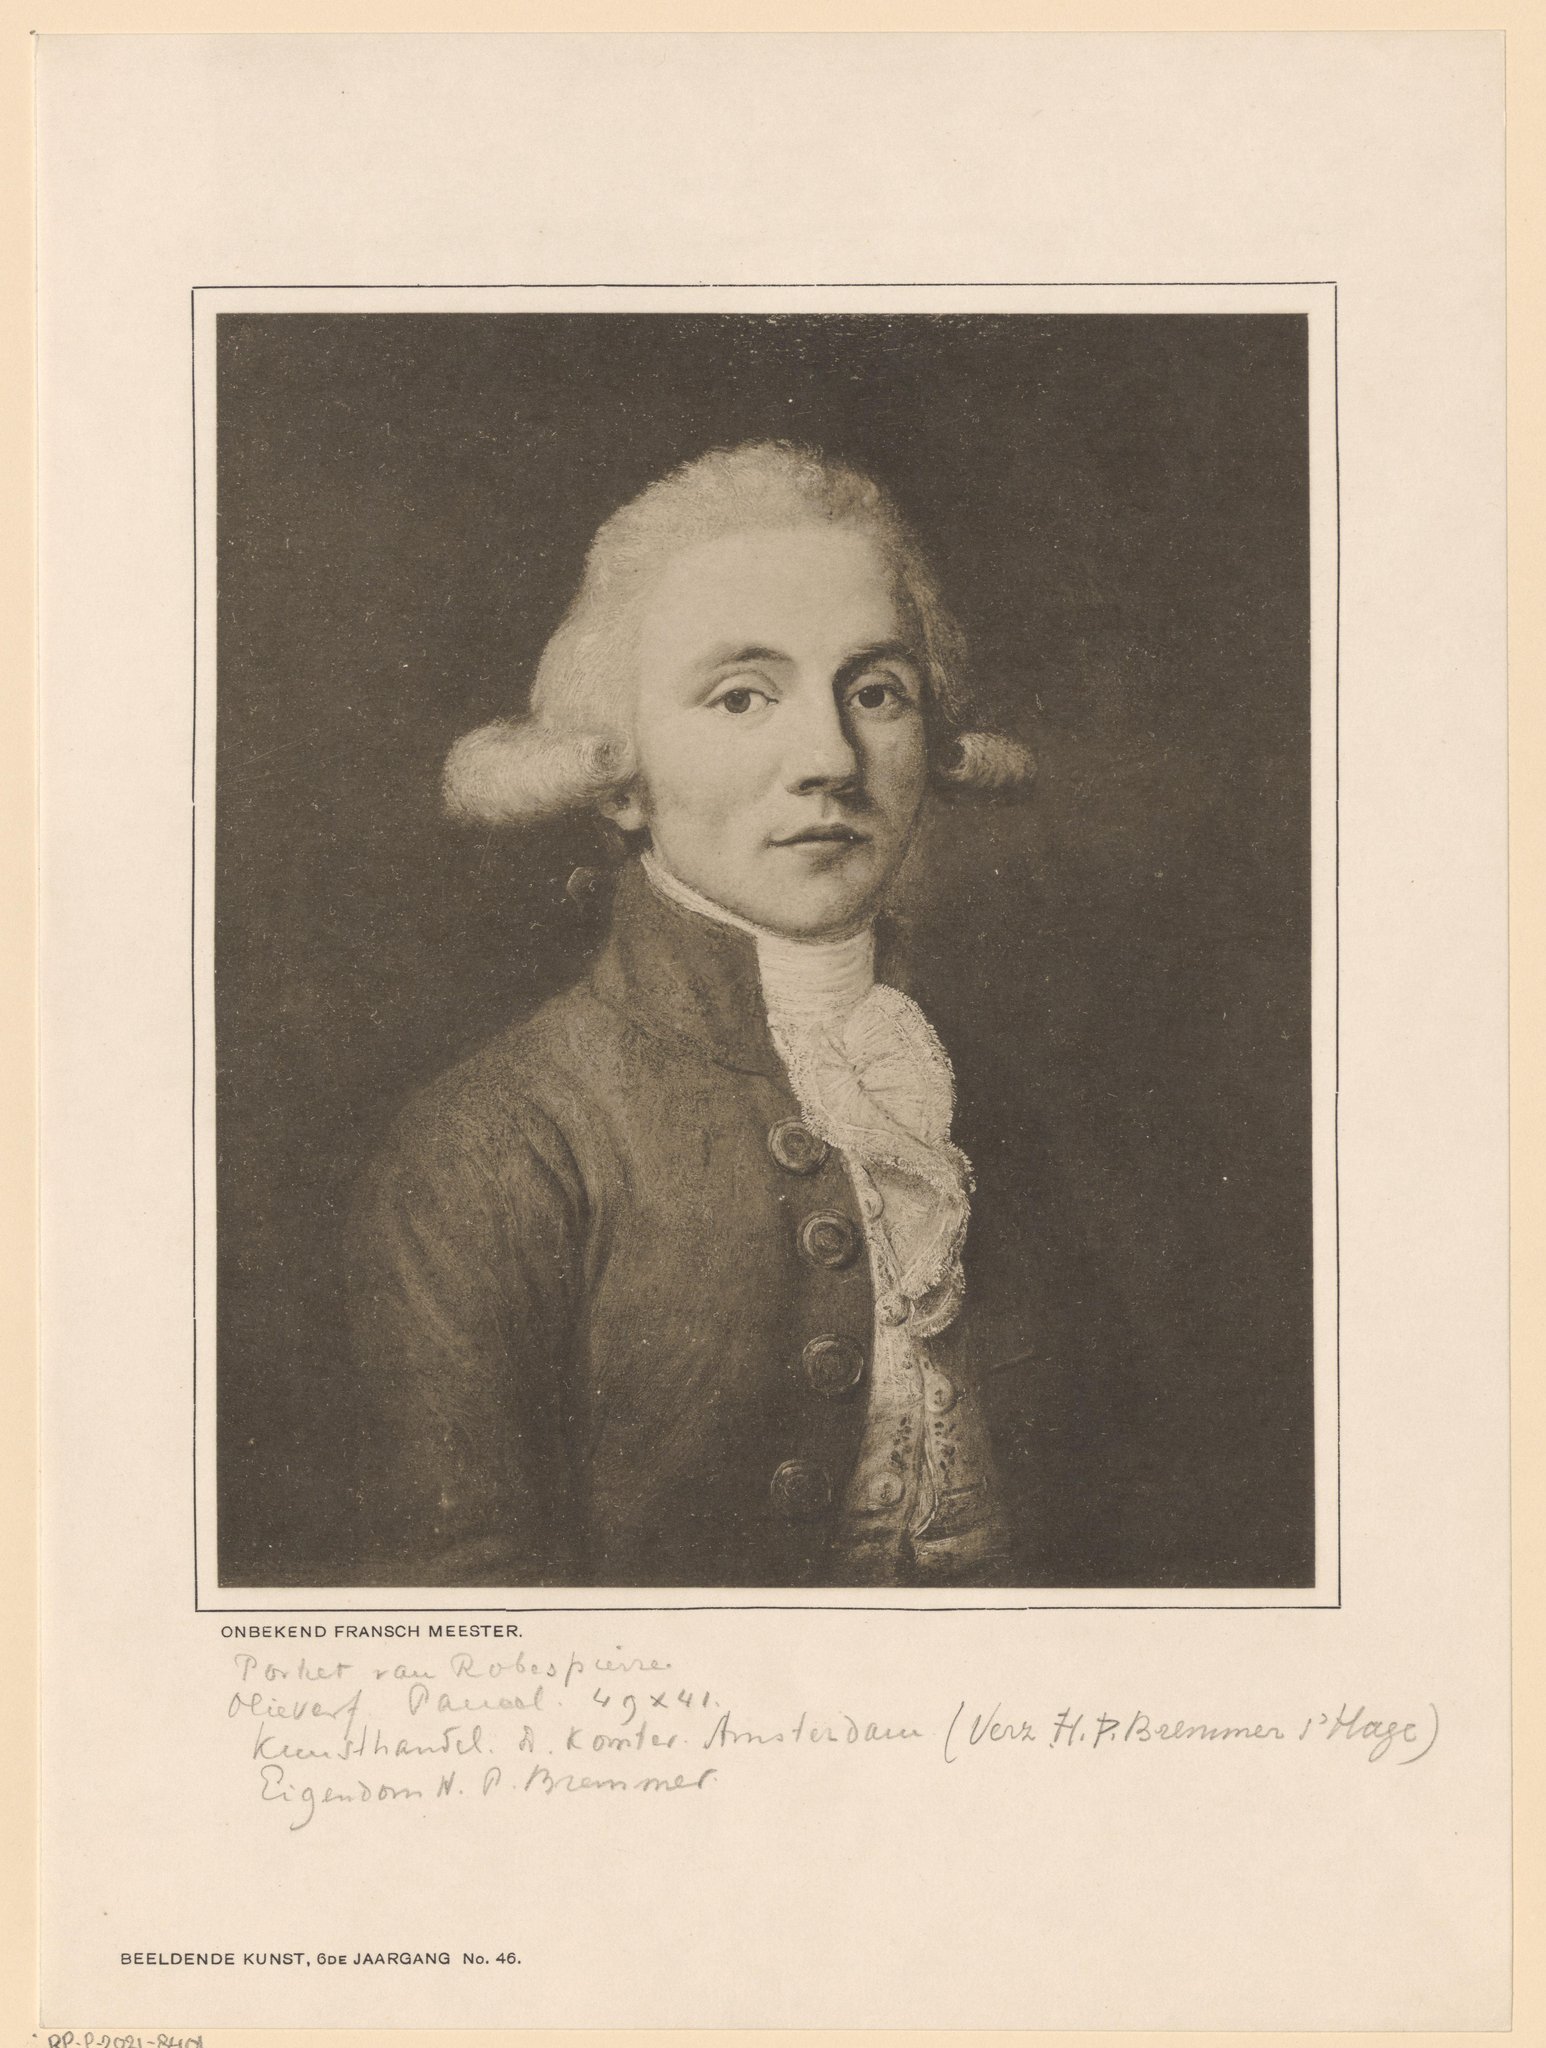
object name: photomechanical print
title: Portret van Maximilien-Marie-Isidore de Robespierre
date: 1918-1919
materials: paper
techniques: photograph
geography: utrecht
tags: paris, historical persons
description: Prent uit: Beeldende kunst 6, nr. 46, 1918-1919.